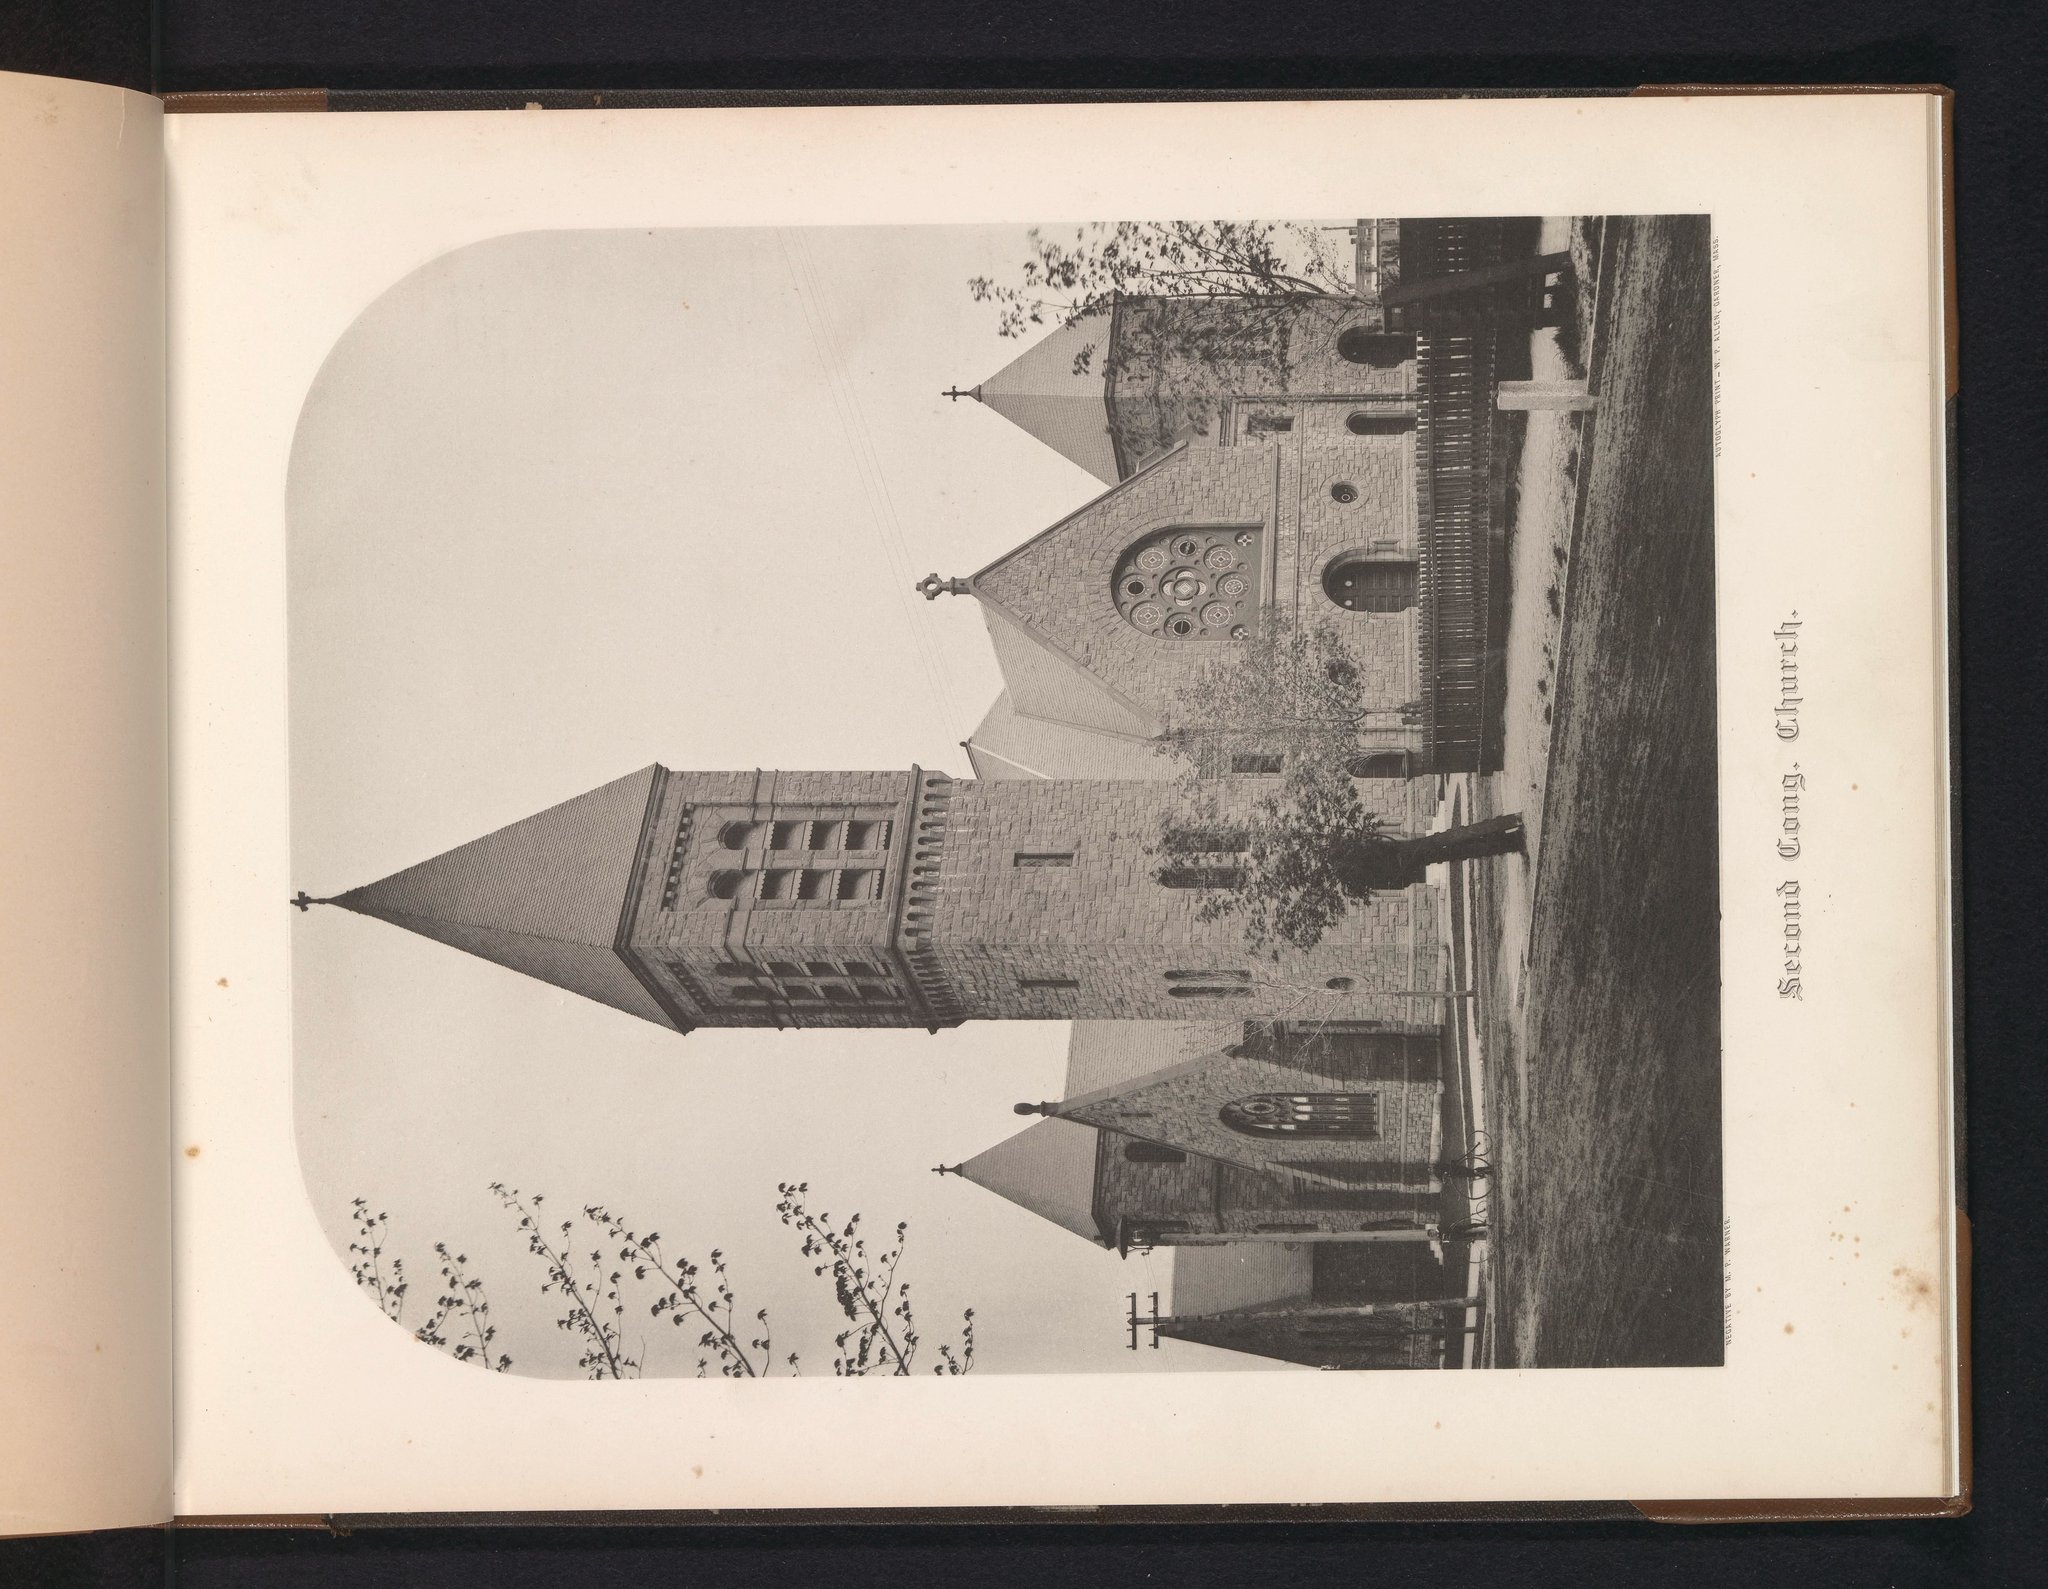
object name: page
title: Second Cong. Church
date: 1883-1888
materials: paper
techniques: photograph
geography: massachusetts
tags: church (exterior), façade (of house or building)